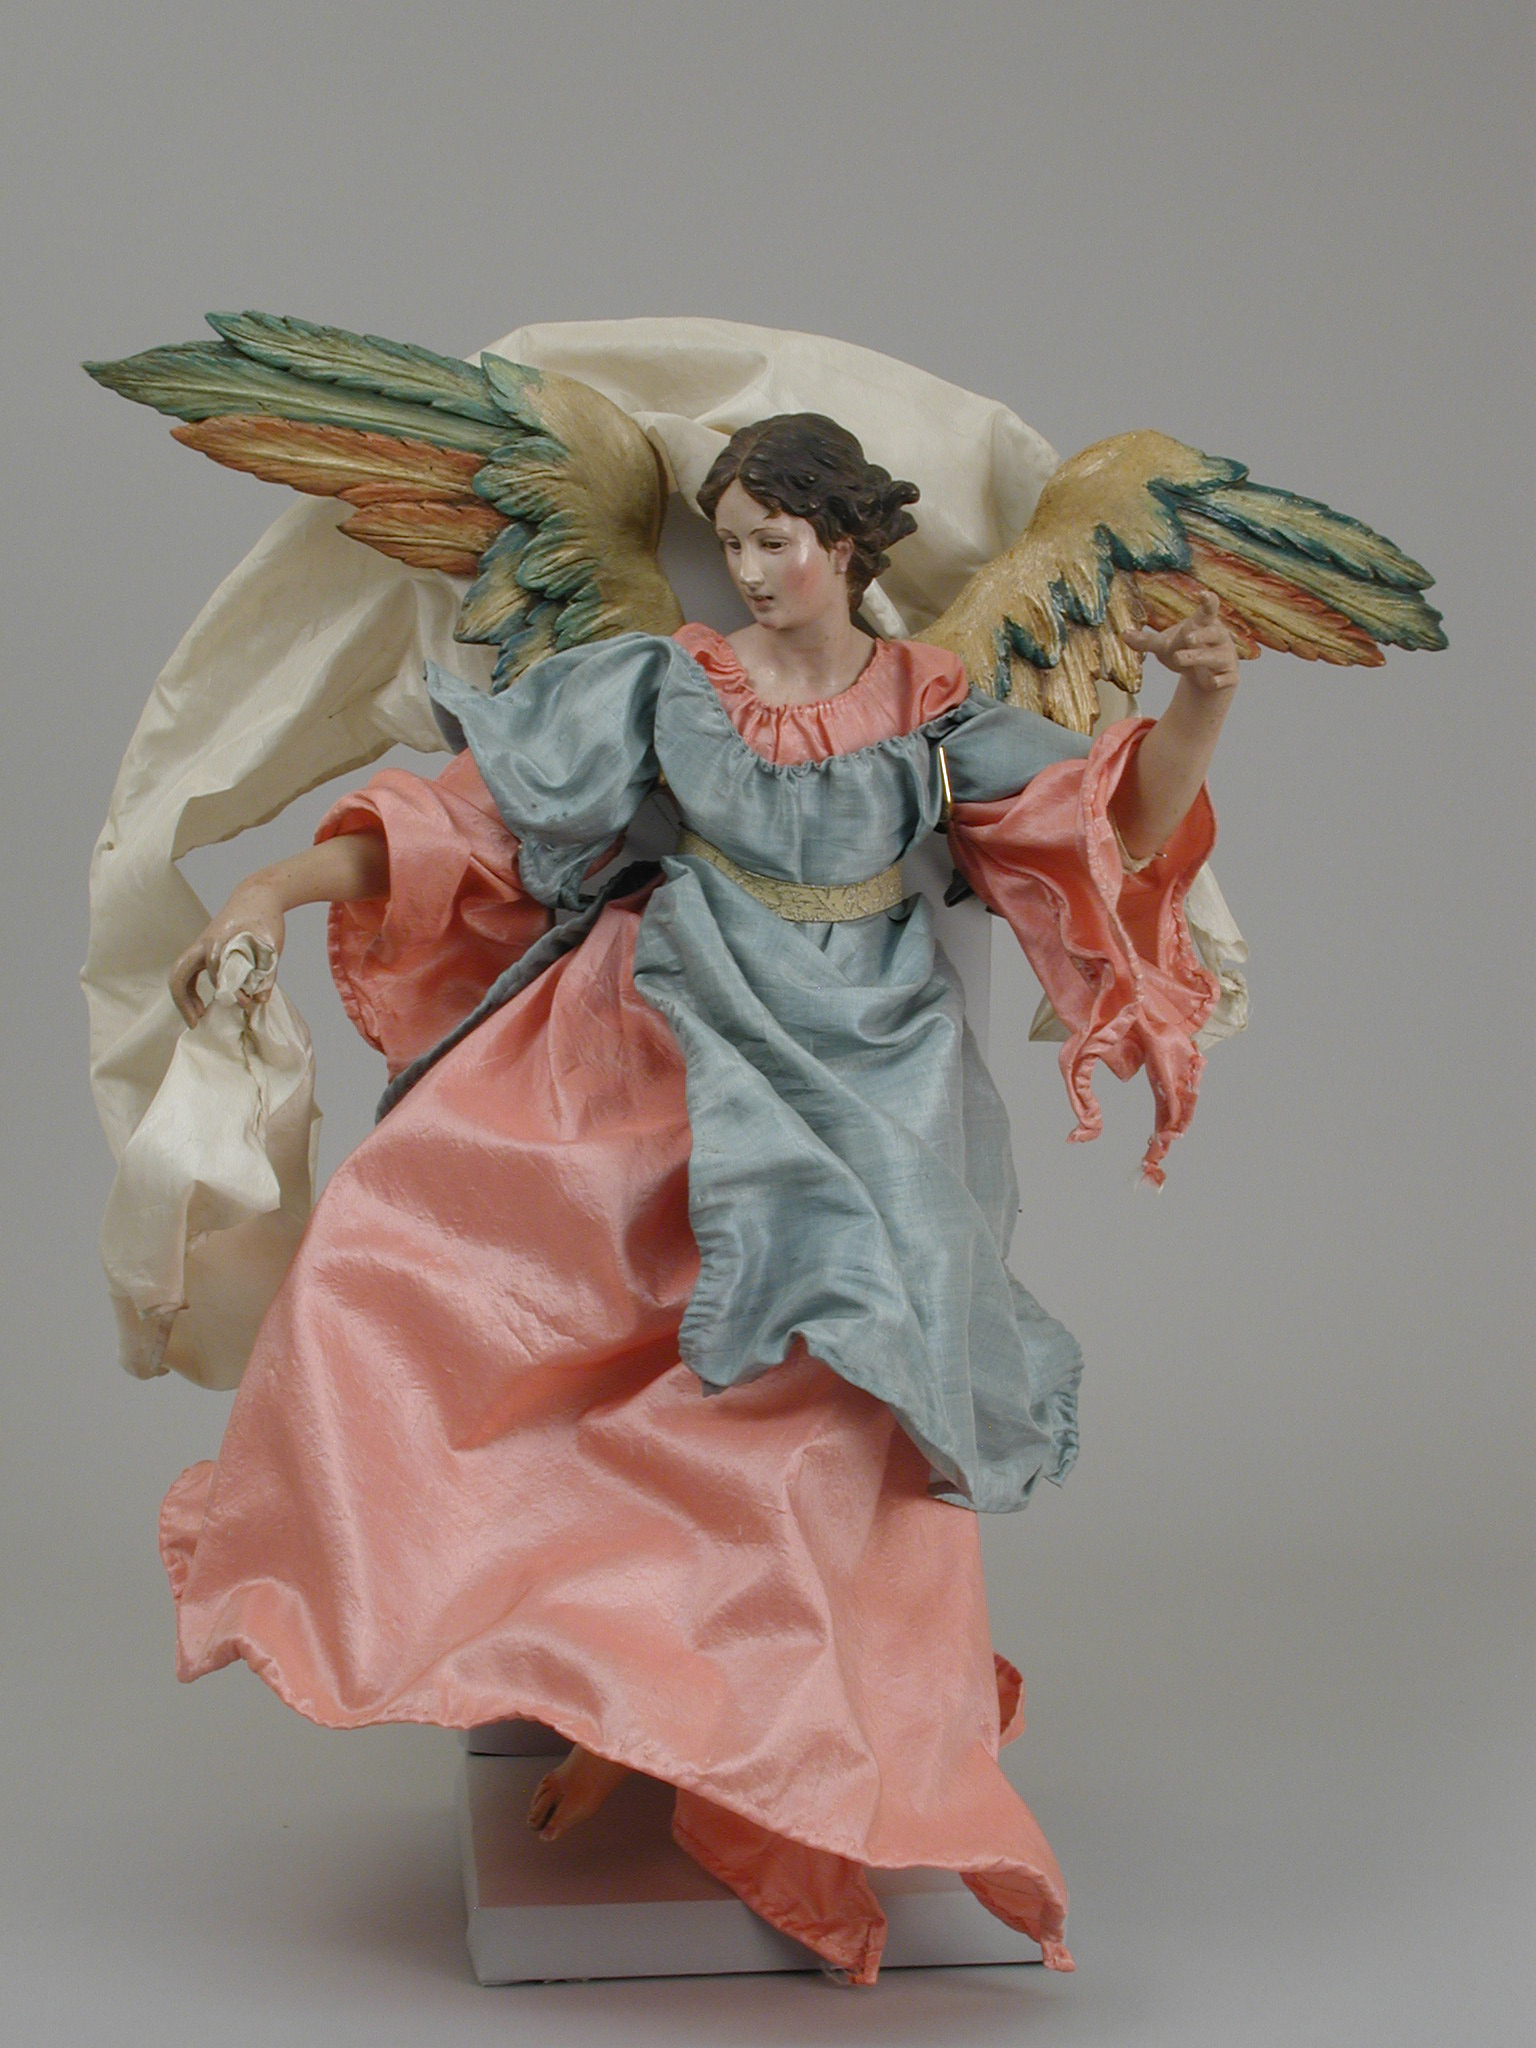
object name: crèche figure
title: Angel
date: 1751-1800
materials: terracotta, fiber, metal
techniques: polychrome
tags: angels